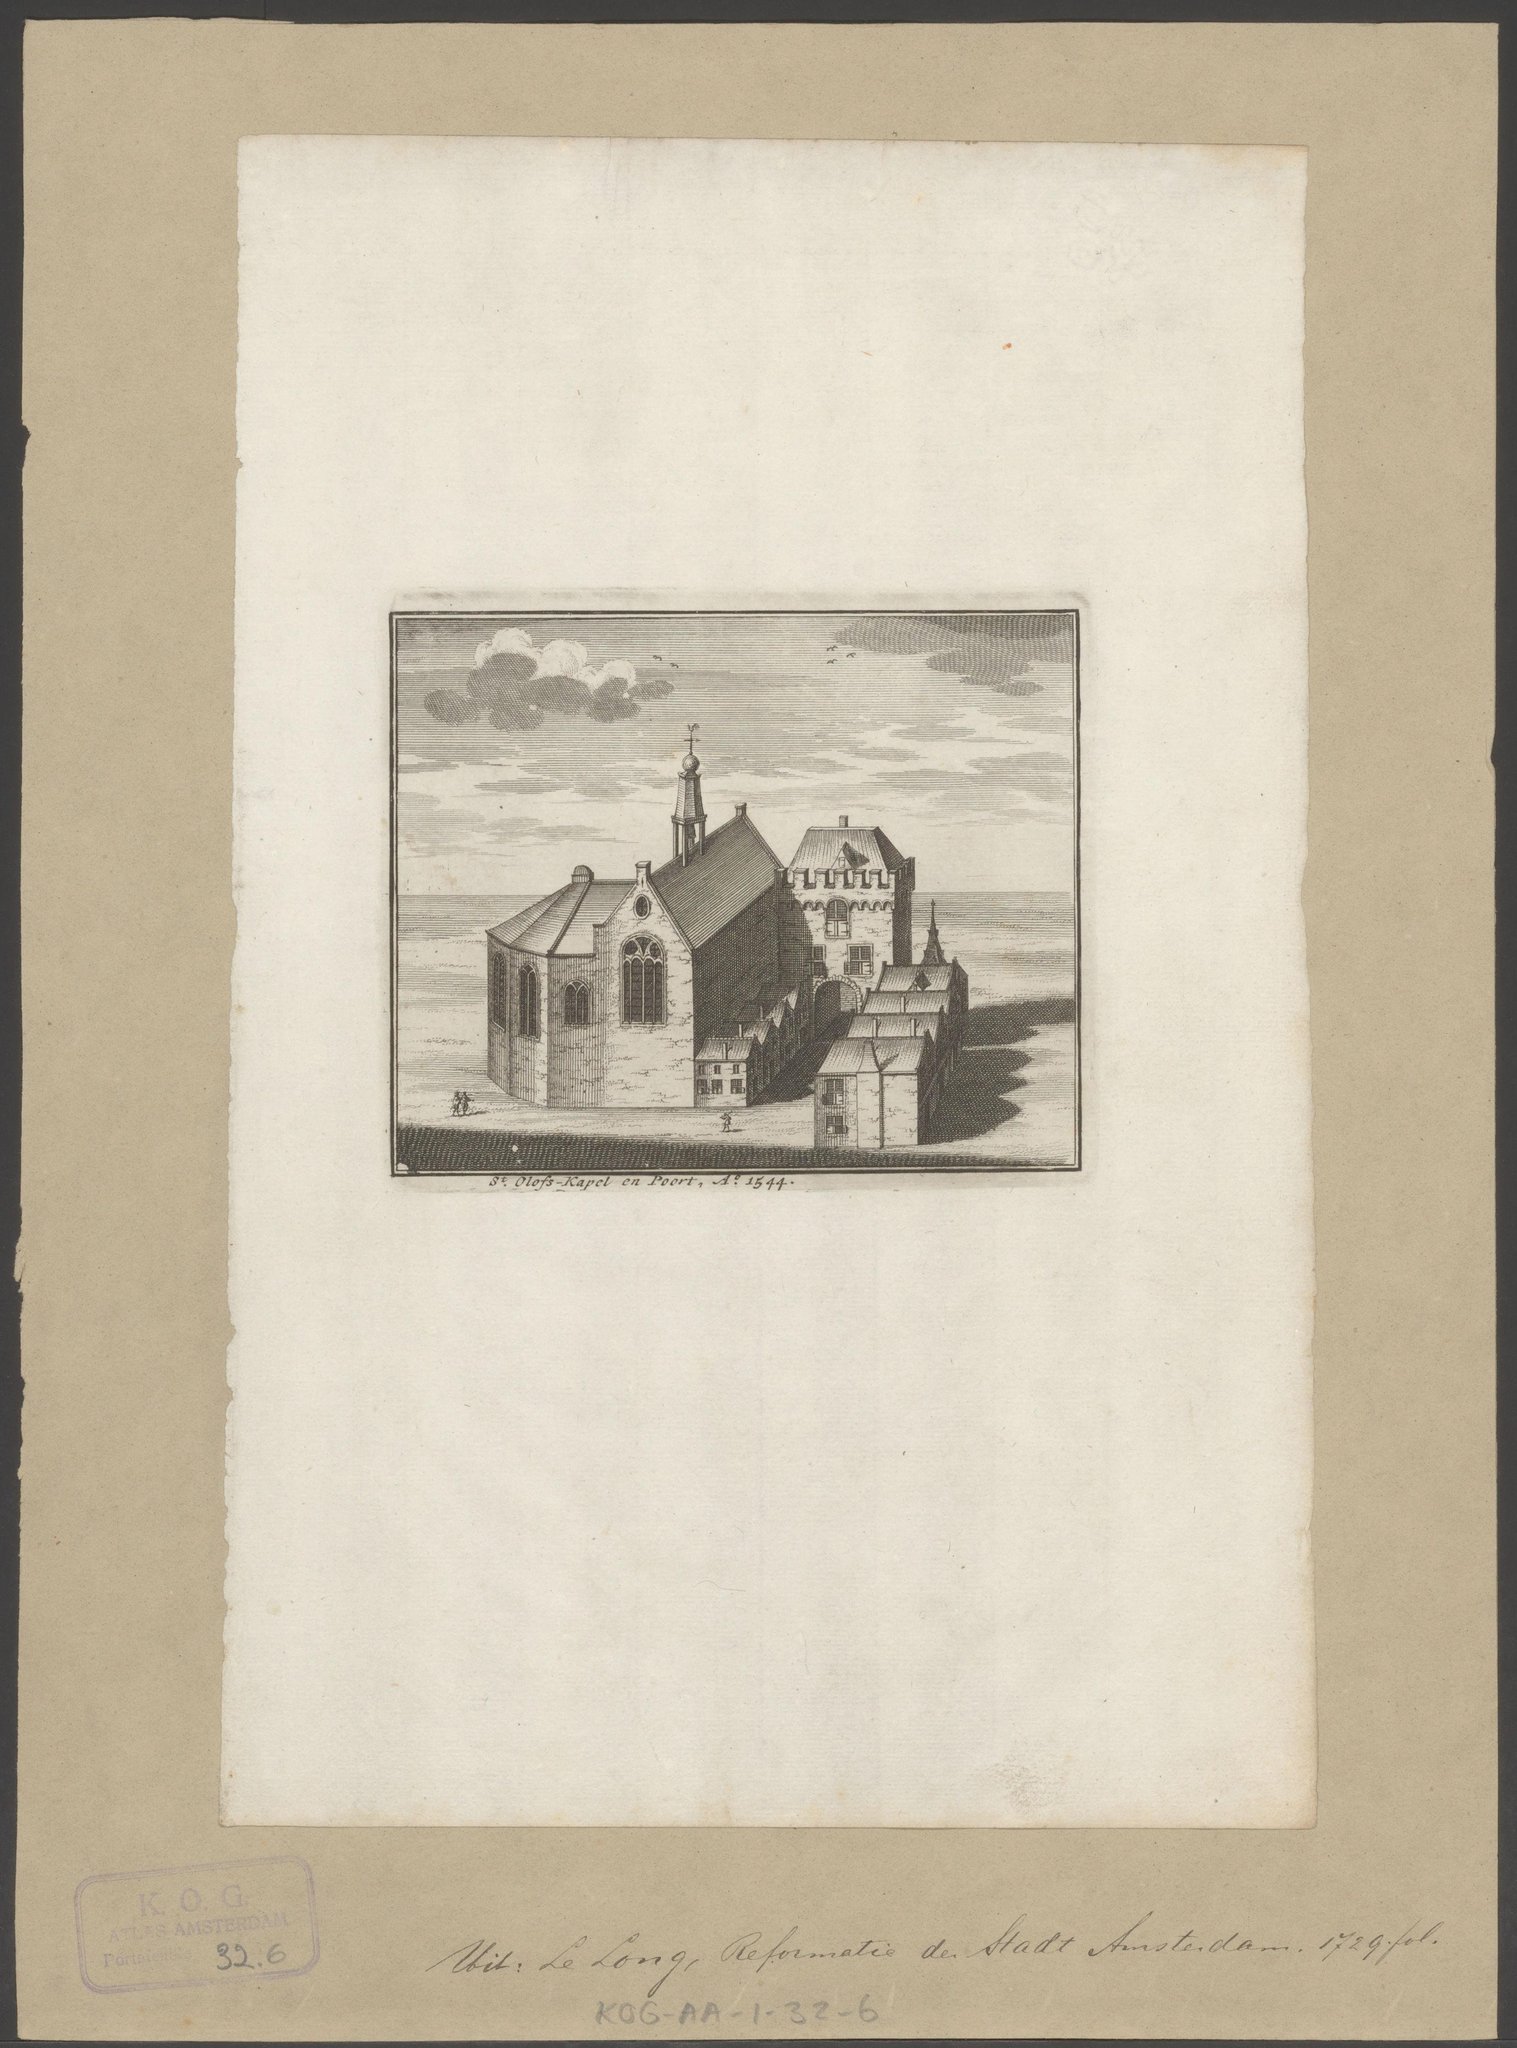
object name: book illustration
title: St. Olofs-Kapel en Poort, Ao. 1544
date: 1729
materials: paper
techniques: engraving, etching, letterpress printing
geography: amsterdam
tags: bird's eye view ~ representation of building, church (exterior) - qq - small church, chapel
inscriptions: collector's mark: ‘32.6’ Lugt 1641b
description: Prent uit: Long, Isaac le. Historische beschryvinge van de reformatie der stadt Amsterdam (…). Amsterdam: Johannes van Septeren (I), 1729, tussen p. 90-91.